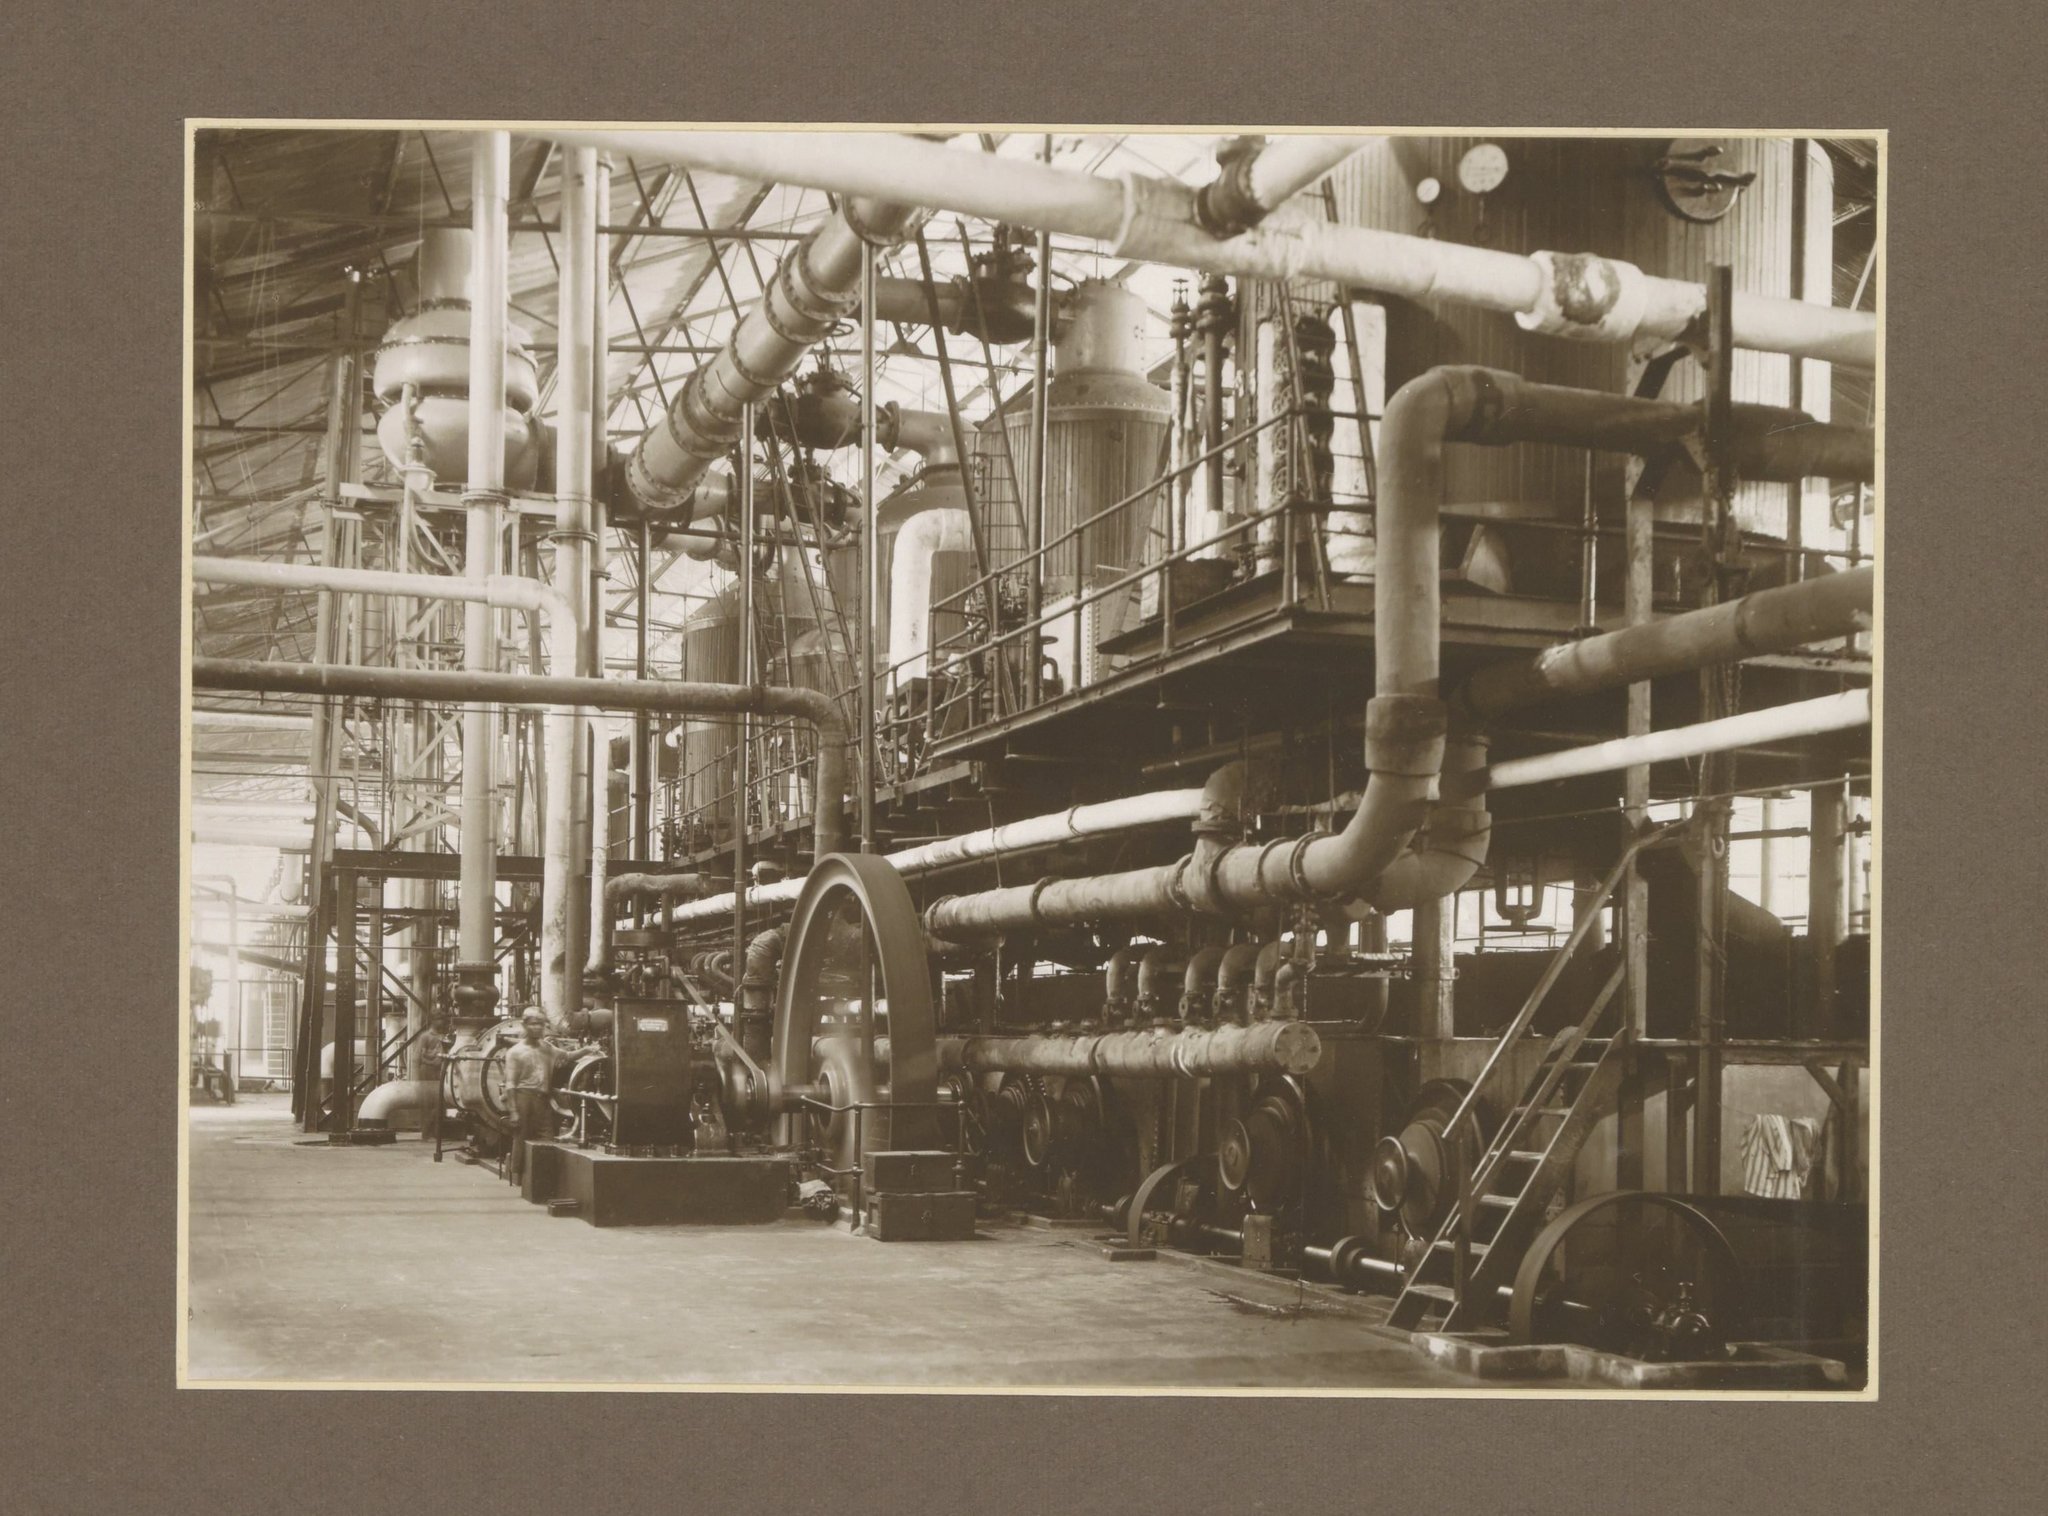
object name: album leaf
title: Hal met machines van suikerfabriek Goedo te Djombang op Java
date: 1925-1930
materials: cardboard, paper, photographic support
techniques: gelatin silver print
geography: jombang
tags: plantation, factory-interior, machine shop, plants and herbs: sugarcane, sugar, dutch east indies, the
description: Onderdeel van Fotoalbum met opnames van vier suikerfabrieken op Java.